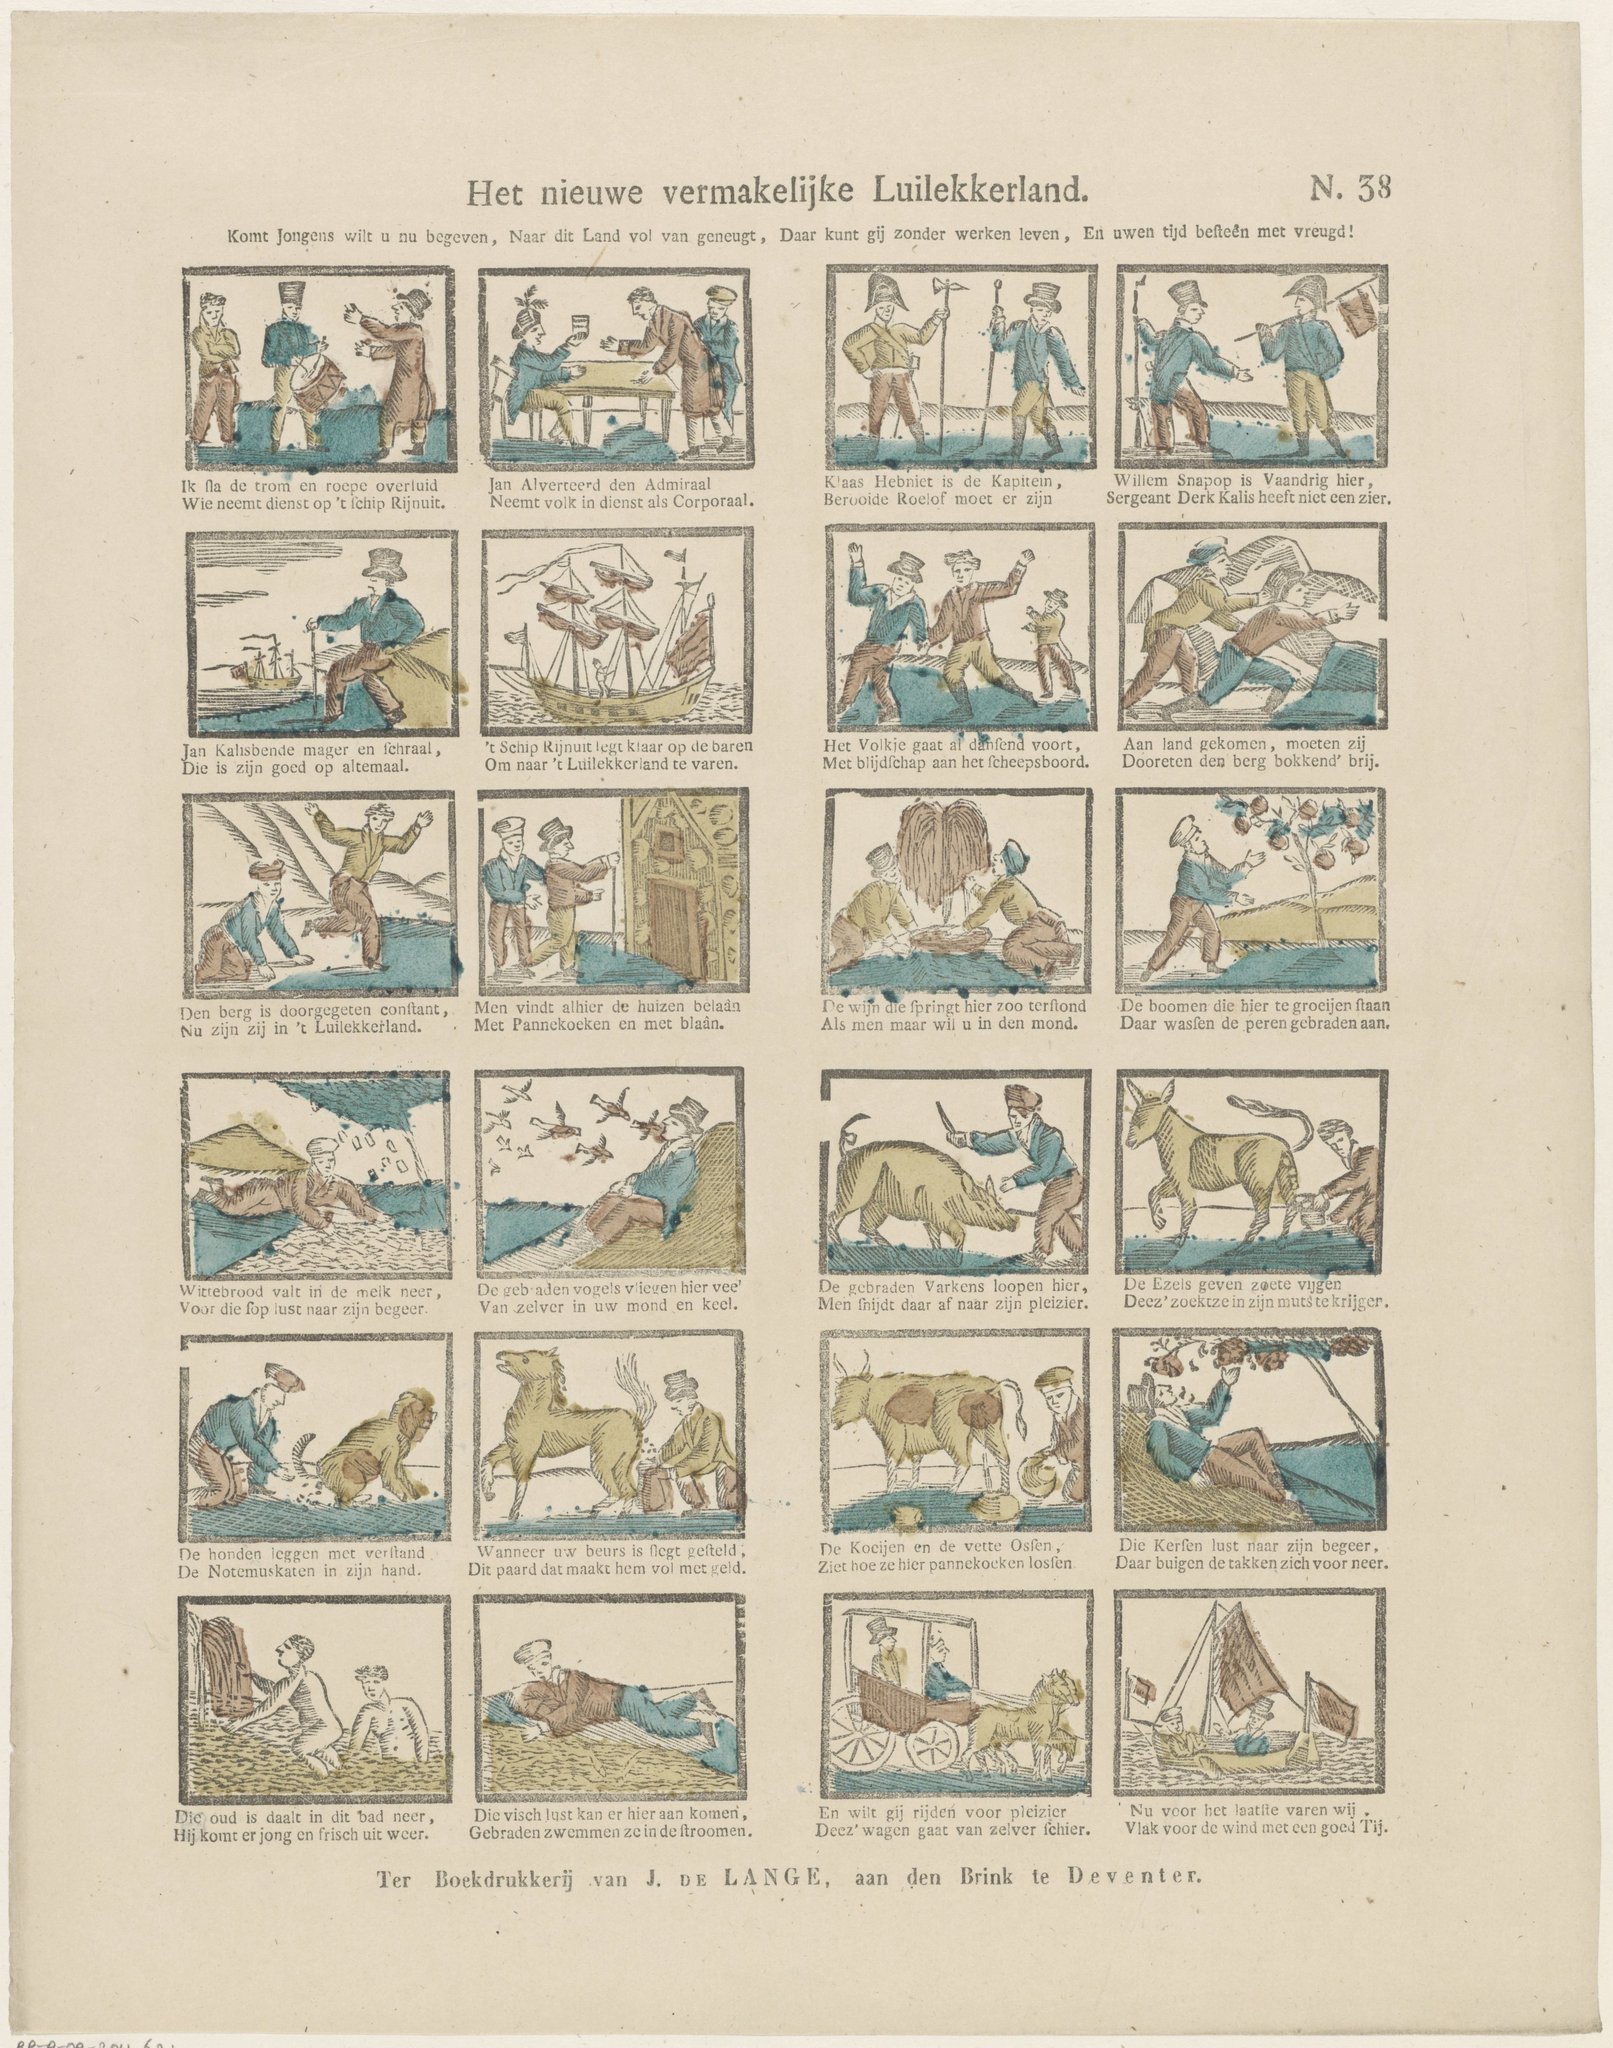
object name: popular print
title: Het nieuwe vermakelijke Luilekkerland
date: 1822-1849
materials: paper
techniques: colour, letterpress printing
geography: netherlands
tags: land of cockaigne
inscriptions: collector's mark: Lugt 2760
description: Blad met 24 voorstellingen van het Luilekkerland. Onder elke afbeelding een tweeregelig vers. Genummerd rechtsboven: N. 38.